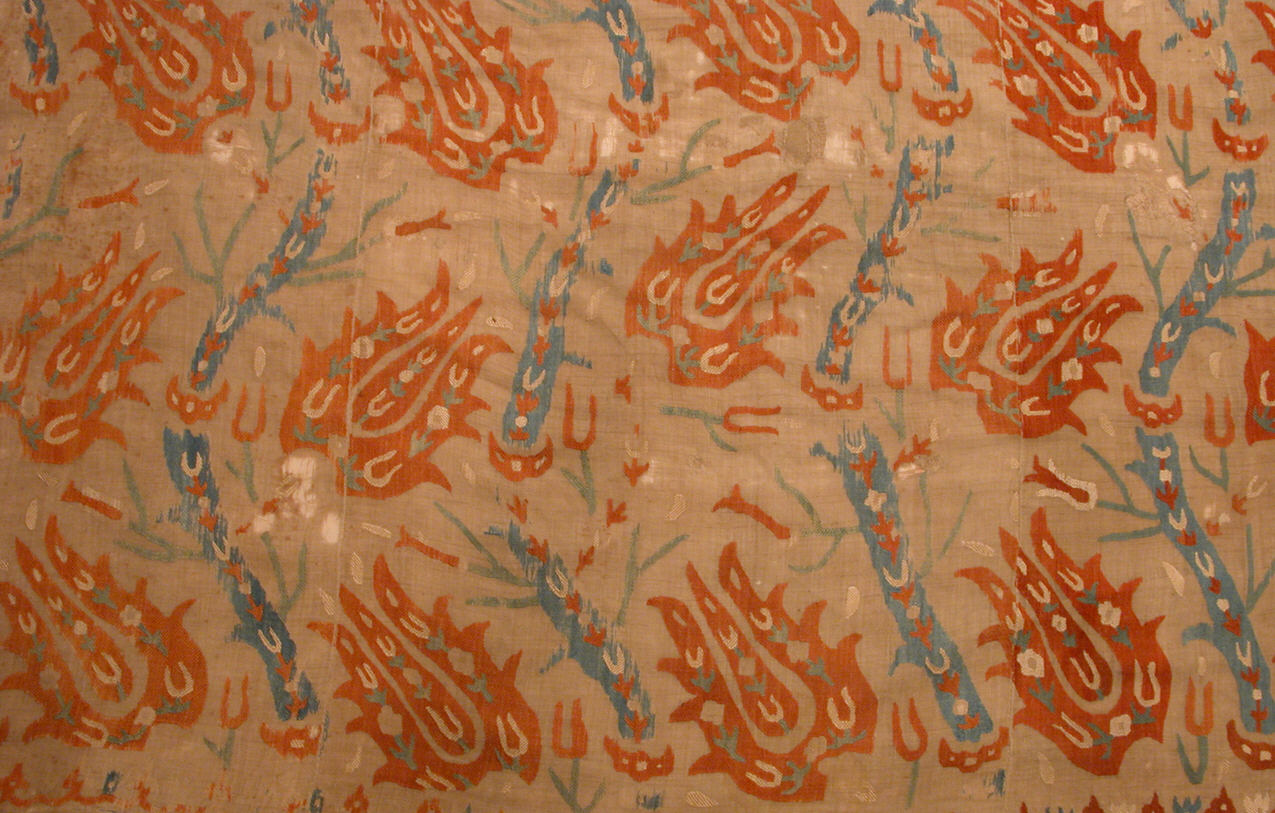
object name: hanging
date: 1601-1800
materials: linen, silk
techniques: embroidery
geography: turkey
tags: flowers